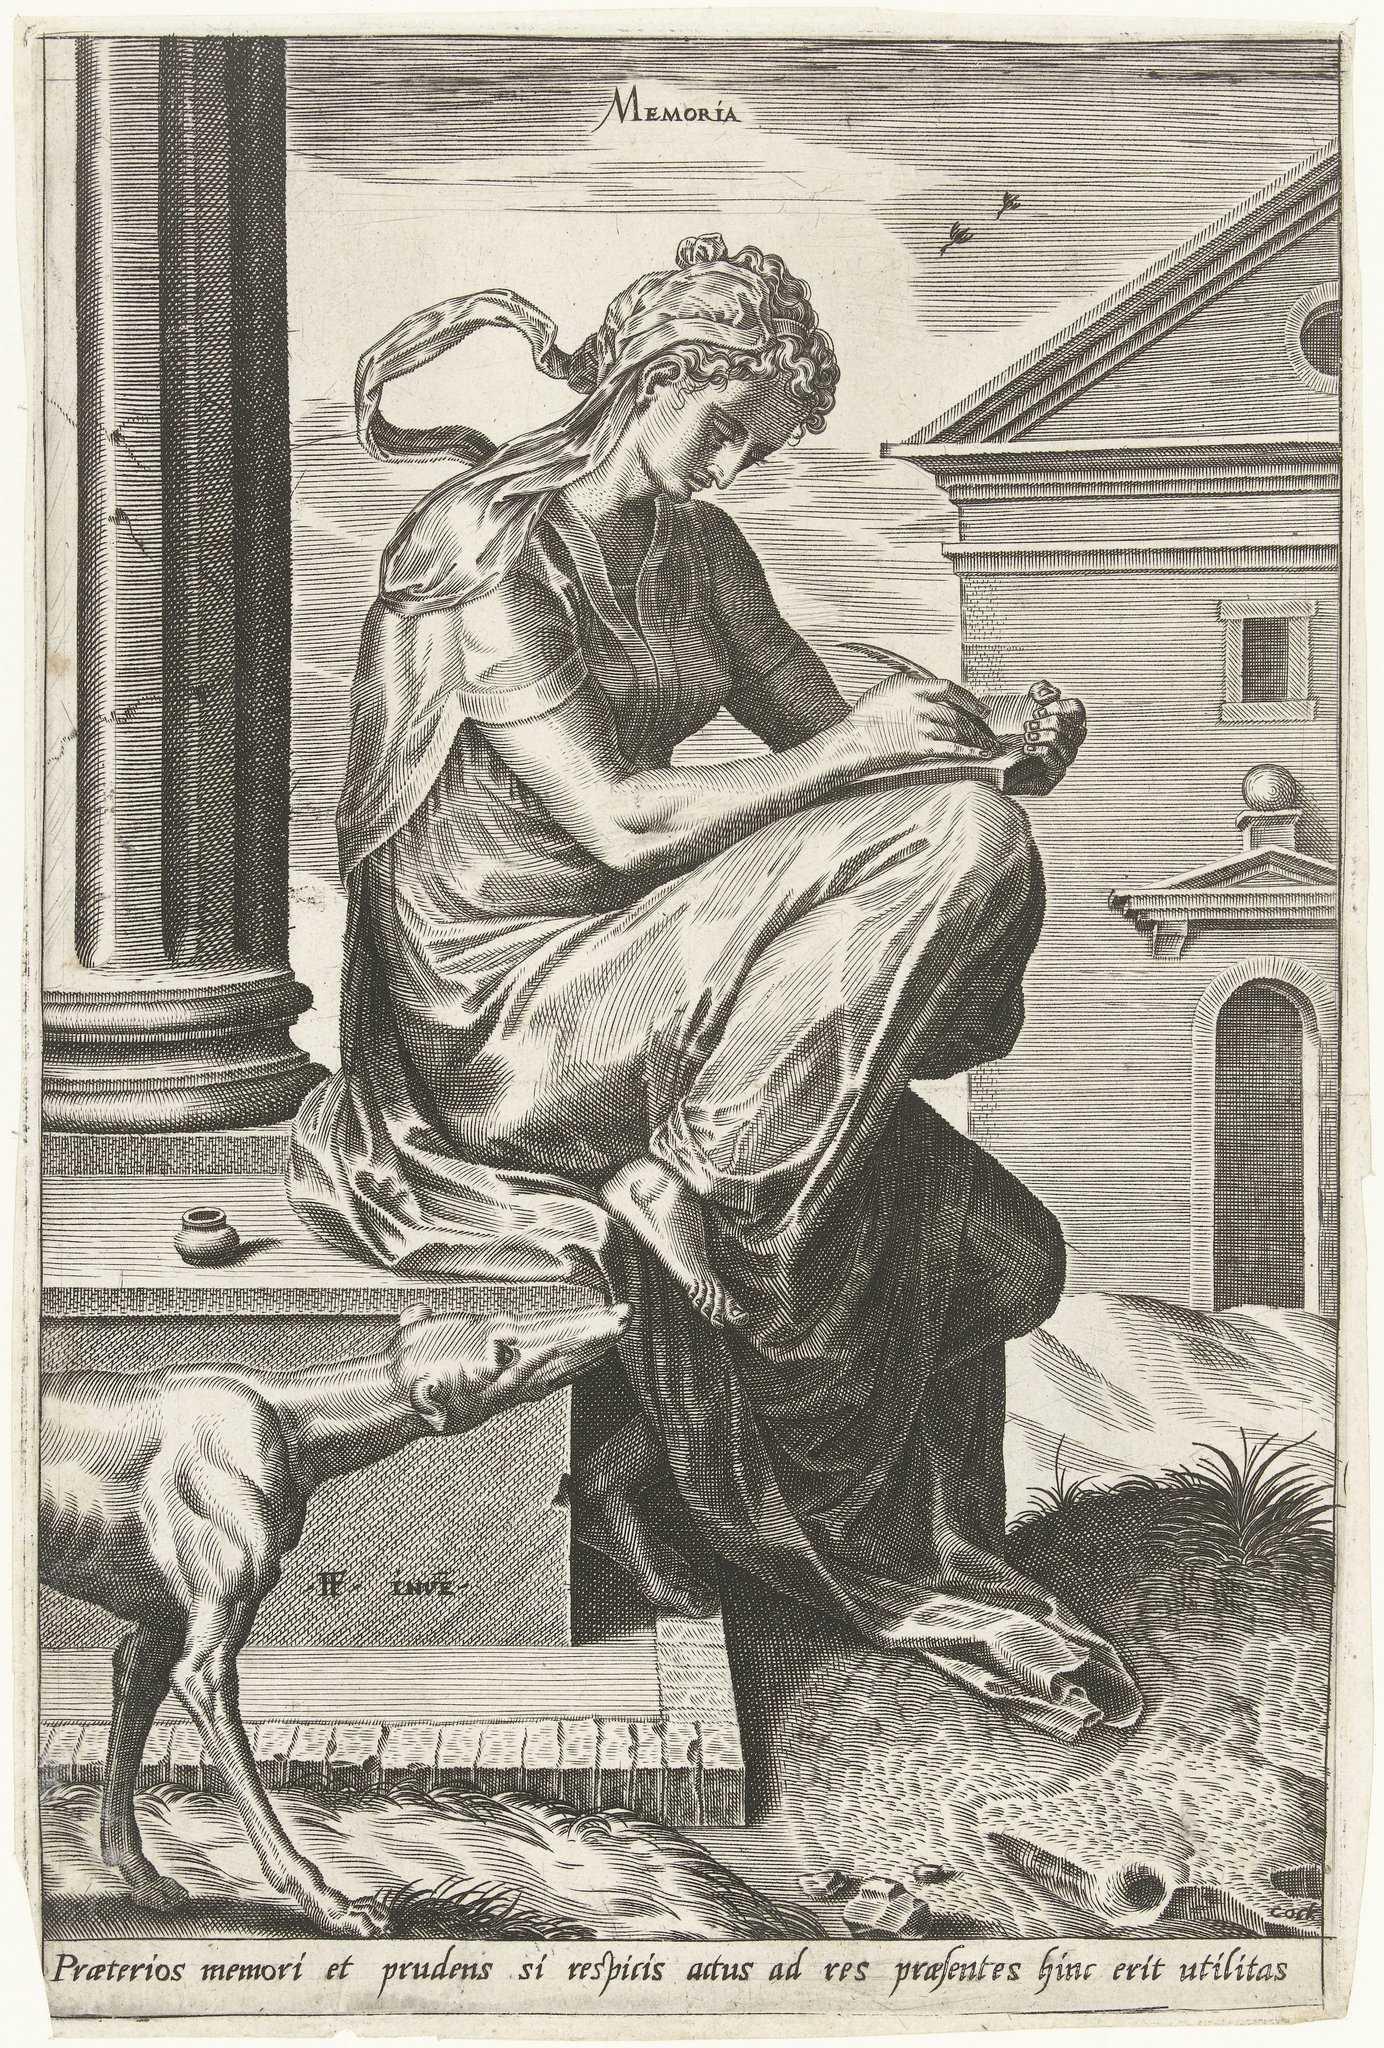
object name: print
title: Deugden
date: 1560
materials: paper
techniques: engraving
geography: antwerp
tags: memory; 'memoria' (ripa)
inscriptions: collector's mark: Lugt 2228, collector's mark: Lugt 2760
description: De personificatie van het Geheugen zit op een sokkel van een antieke zuil en tekent in een boek de geschiedenis op. Naast haar een hond die haar getrouw opwacht. Onder de voorstelling een Latijns vers.